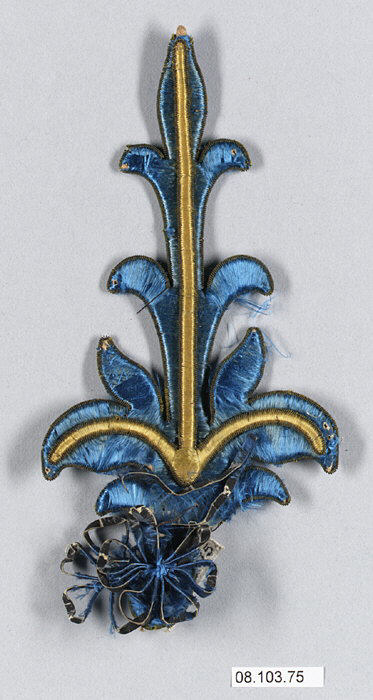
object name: ornament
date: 1801-1900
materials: silk